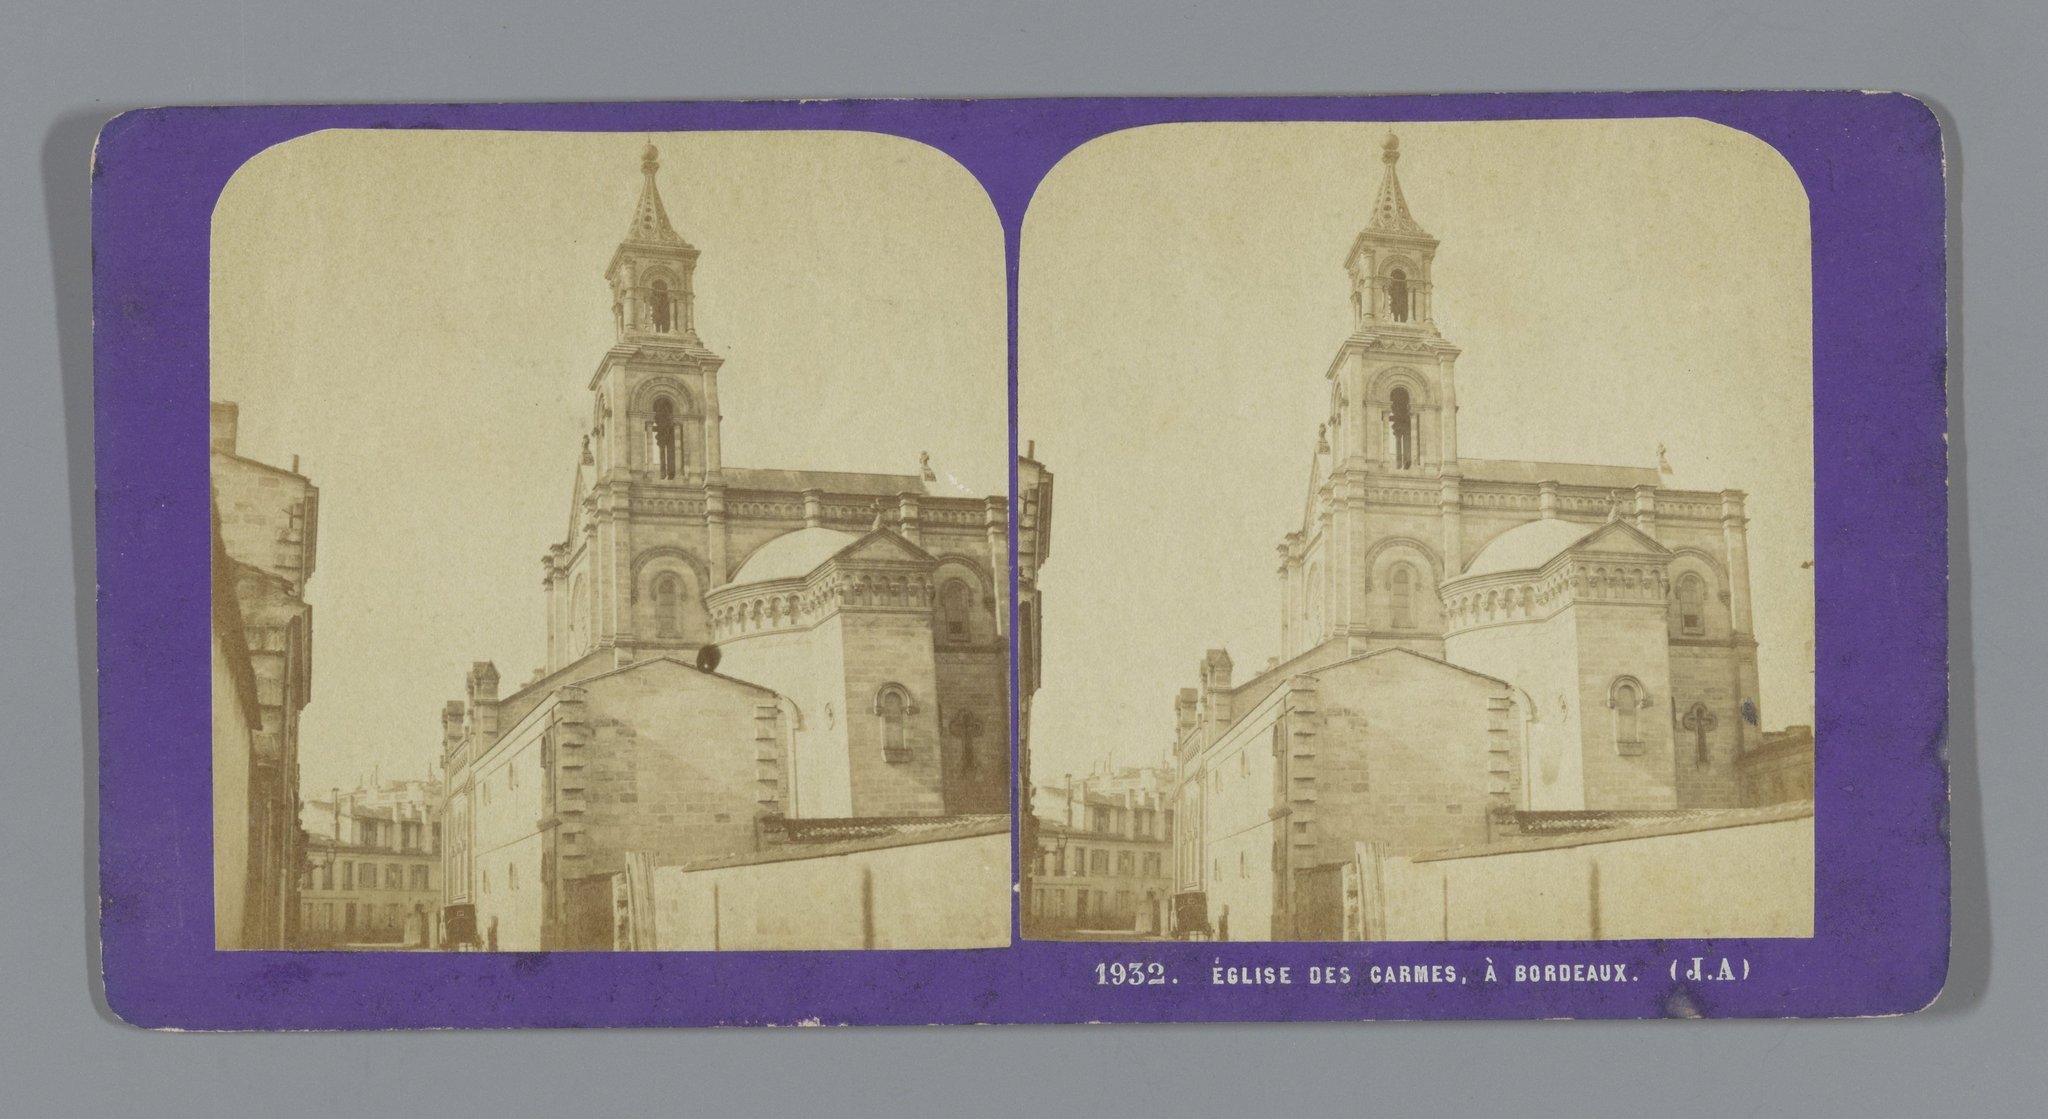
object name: stereograph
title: Église des Carmes, à Bordeaux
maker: jean andrieu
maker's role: fotograaf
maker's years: 1816-1872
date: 1862-1876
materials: cardboard, photographic support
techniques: albumen print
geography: bordeaux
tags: church (exterior), façade (of house or building)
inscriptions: number: ‘1932’